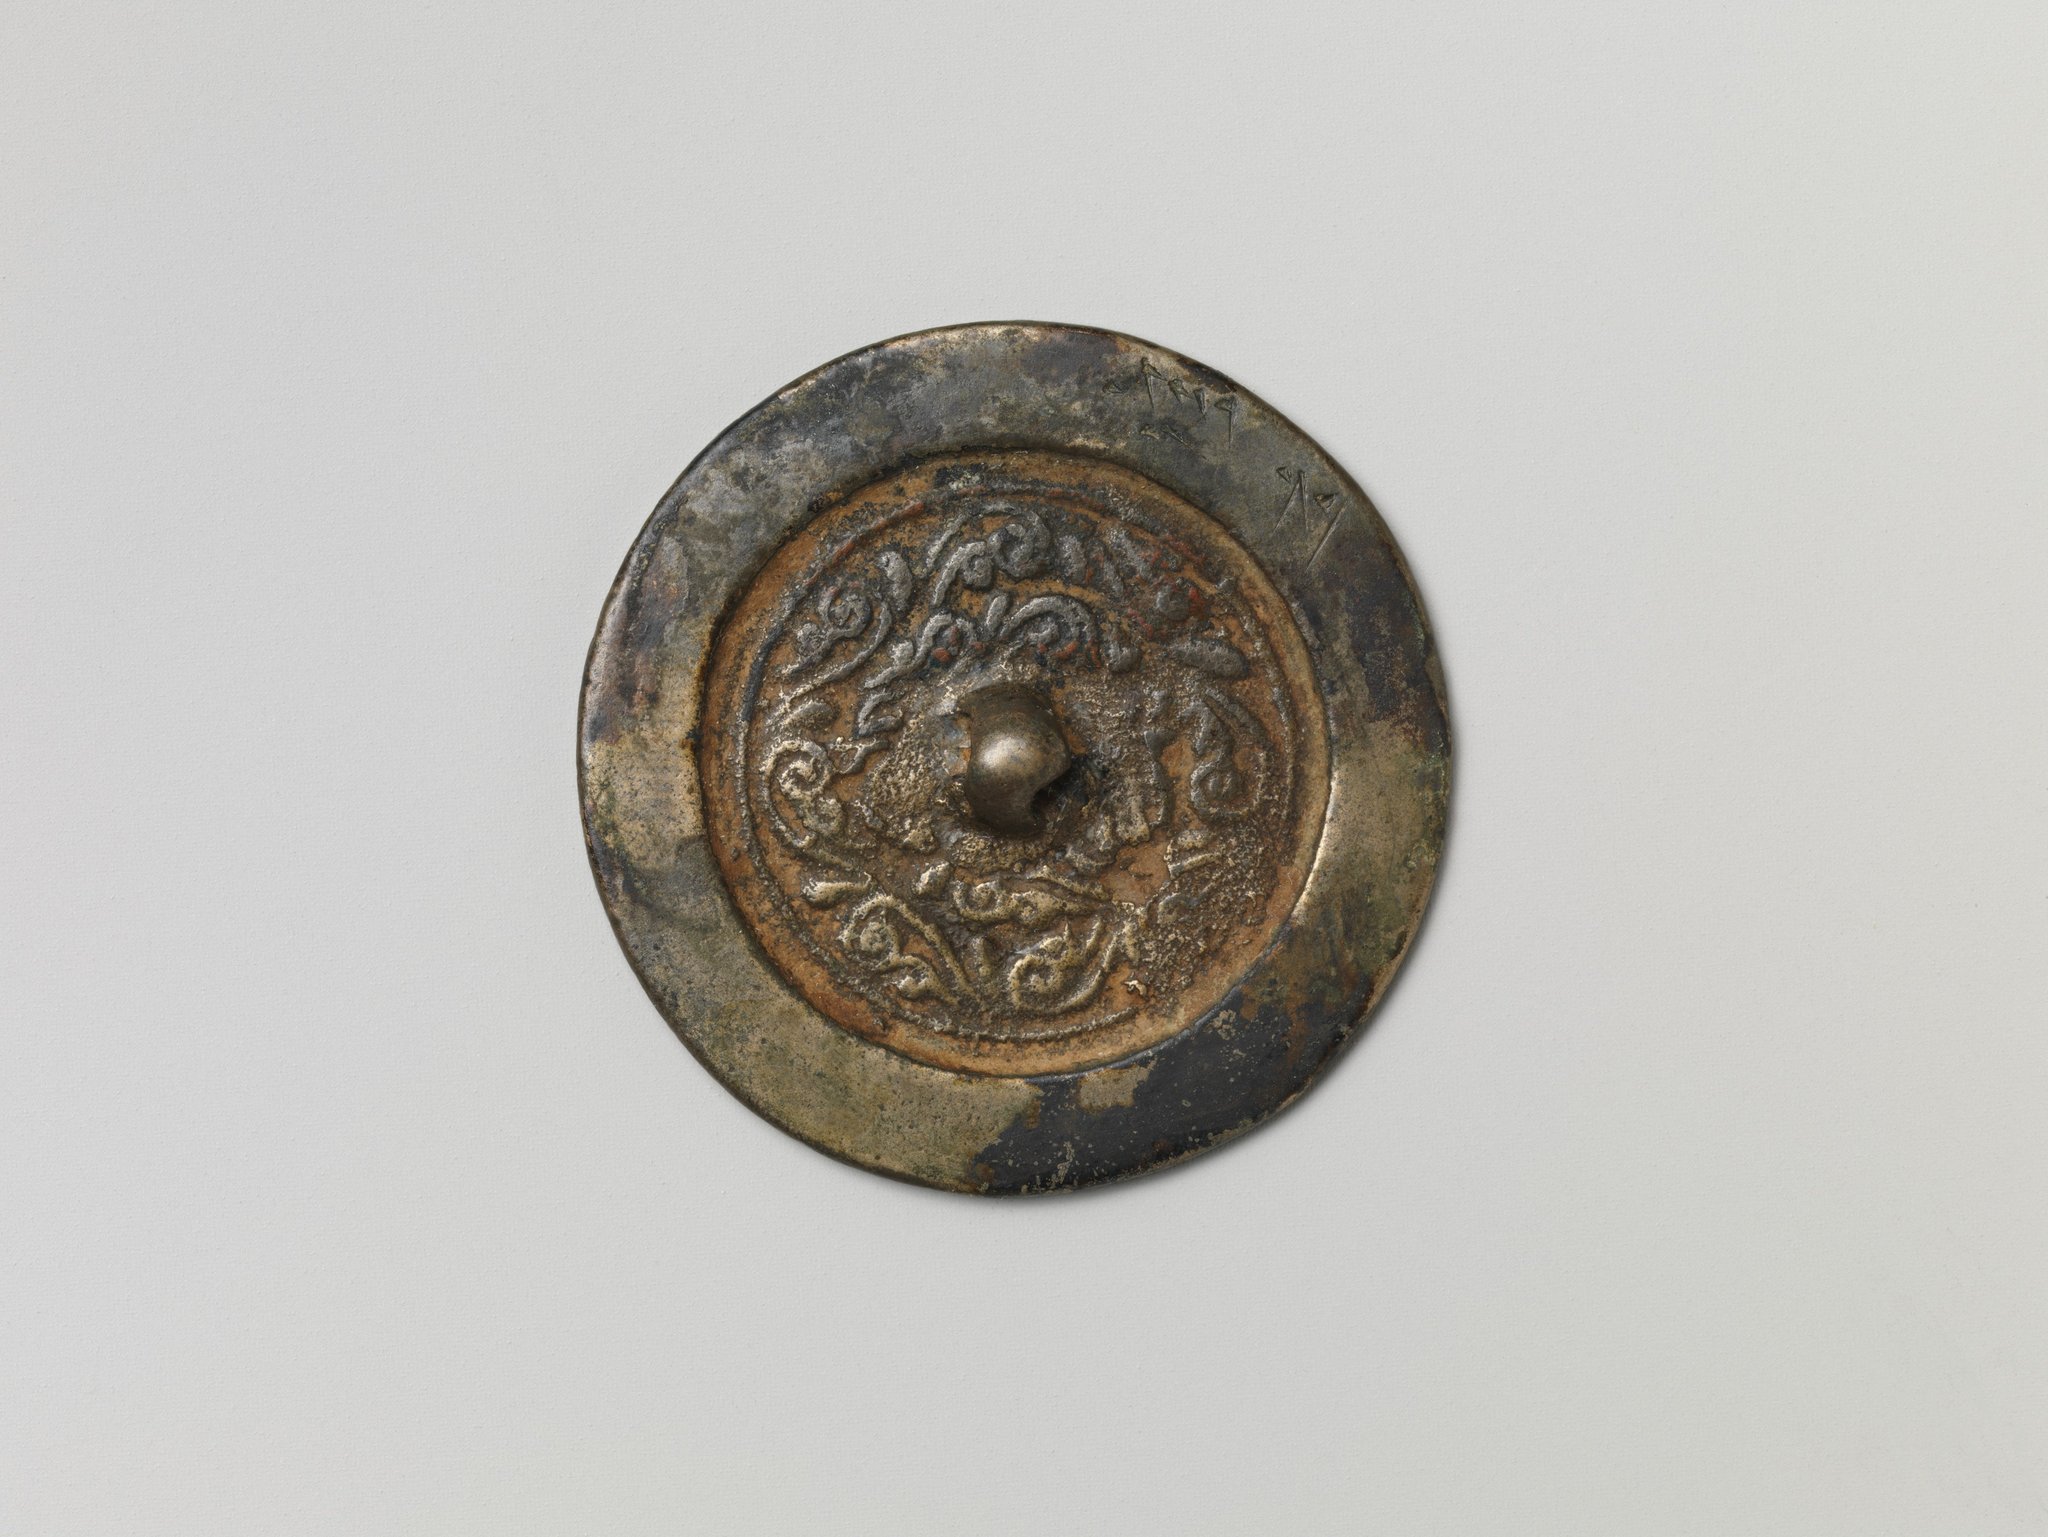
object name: votive mirror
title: Miniature Votive Mirror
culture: chinese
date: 1271-1368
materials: bronze